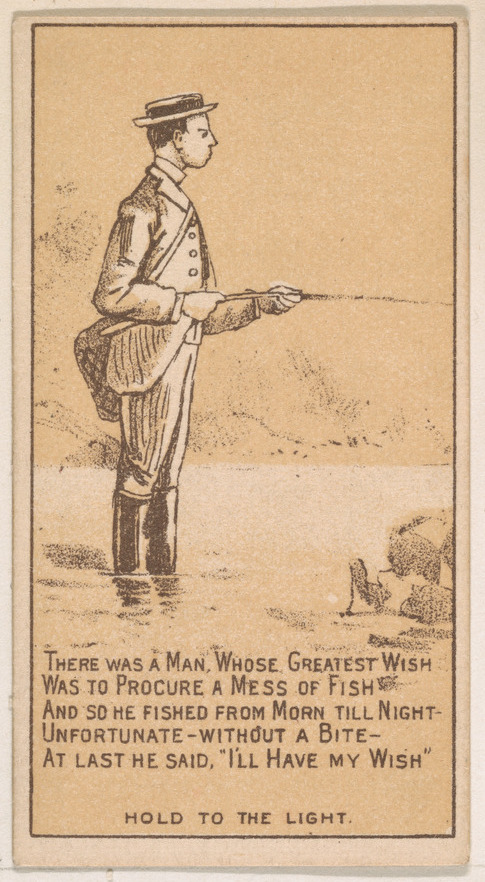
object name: print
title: There Was a Man Whose Greatest Wish..., from the Magic Changing Cards series (N223) issued by Kinney Tobacco Company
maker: kinney brothers tobacco company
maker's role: publisher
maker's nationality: american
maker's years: 1869-2011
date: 1889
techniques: color lithograph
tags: men,profiles,fishing